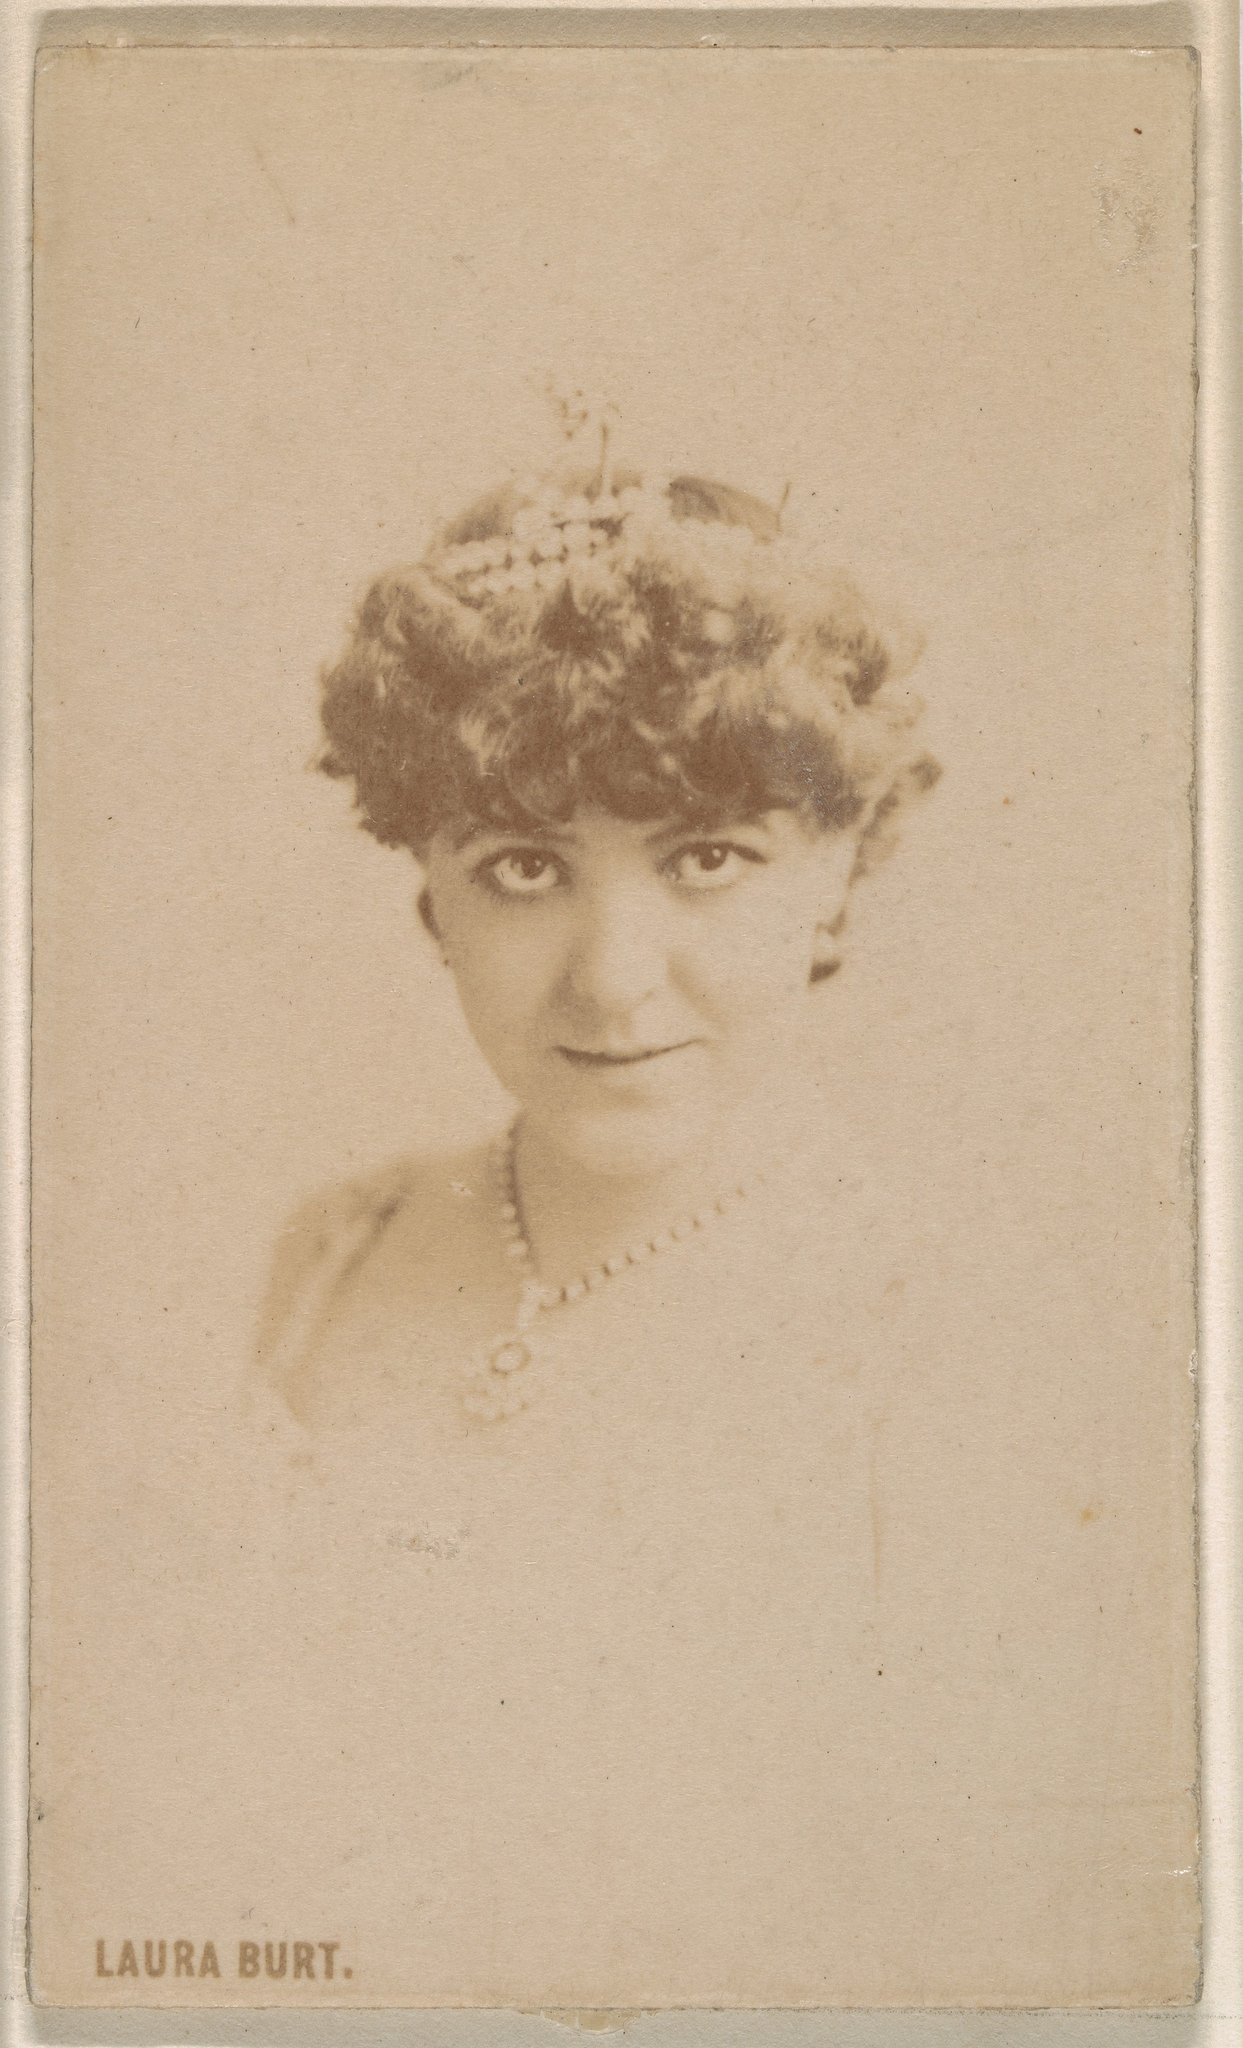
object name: photograph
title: Laura Burt, from the Actresses series (N246), Type 1, issued by Kinney Brothers to promote Sporting Extra Cigarettes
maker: kinney brothers tobacco company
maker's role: publisher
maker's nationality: american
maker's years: 1869-2011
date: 1890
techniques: albumen silver print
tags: portraits,women,actresses